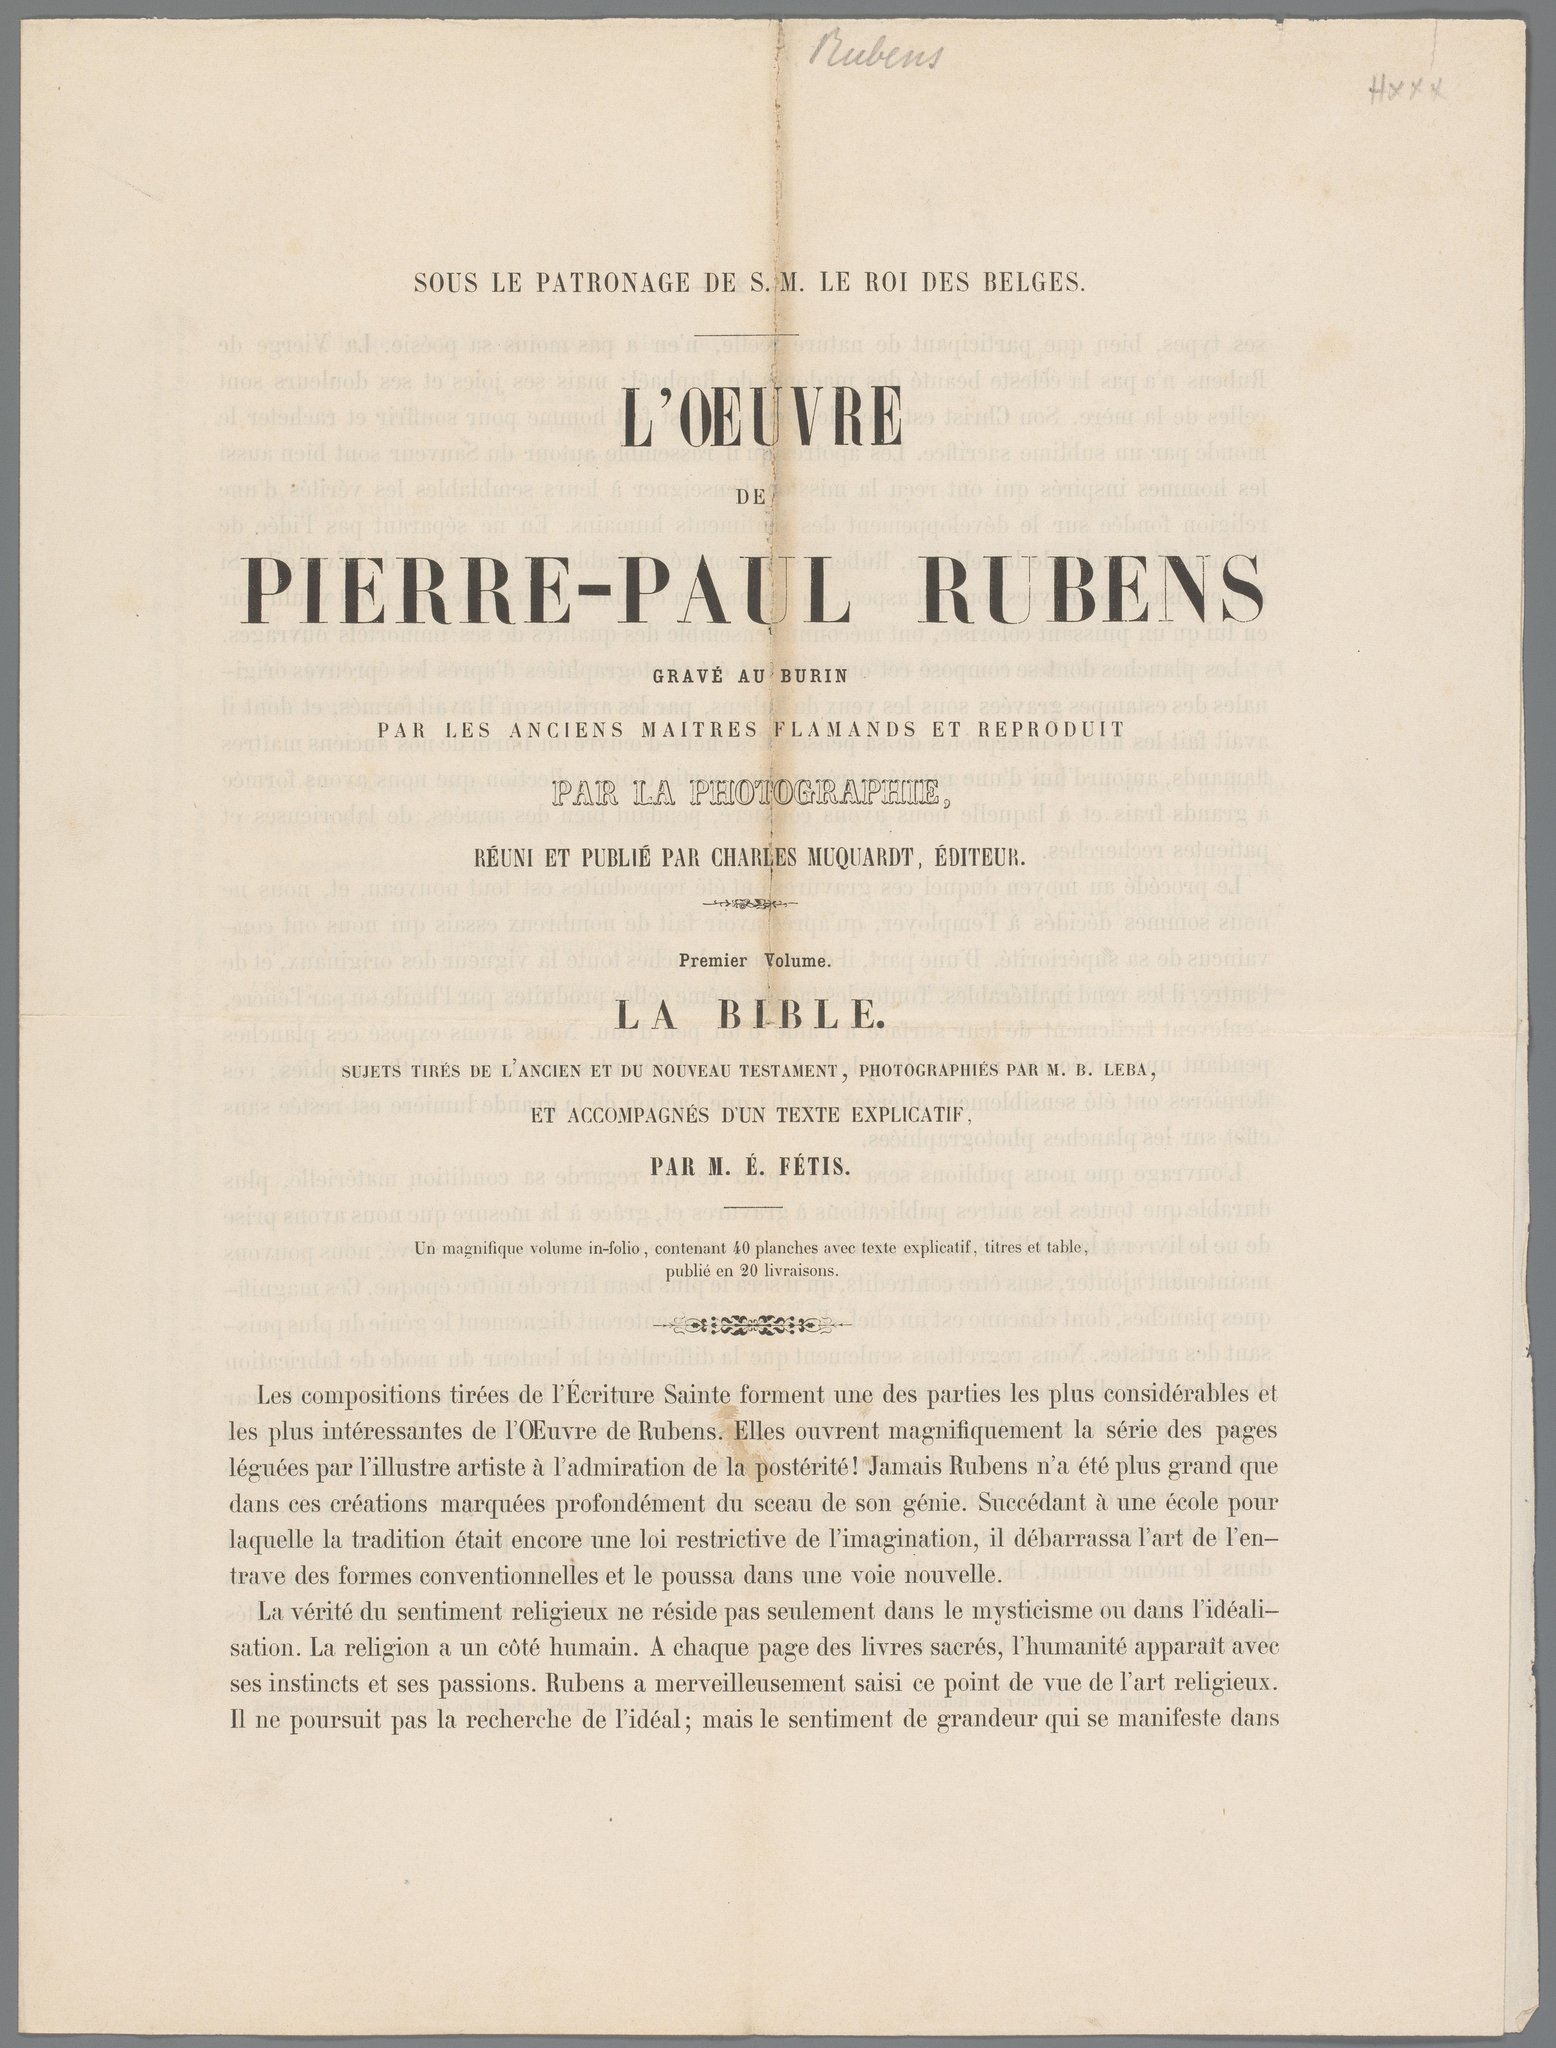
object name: pamphlet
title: l'Oeuvre de Pierre-Paul Rubens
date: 1857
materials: paper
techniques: printing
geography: brussels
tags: single printed leaf: broadsheet, leaflet